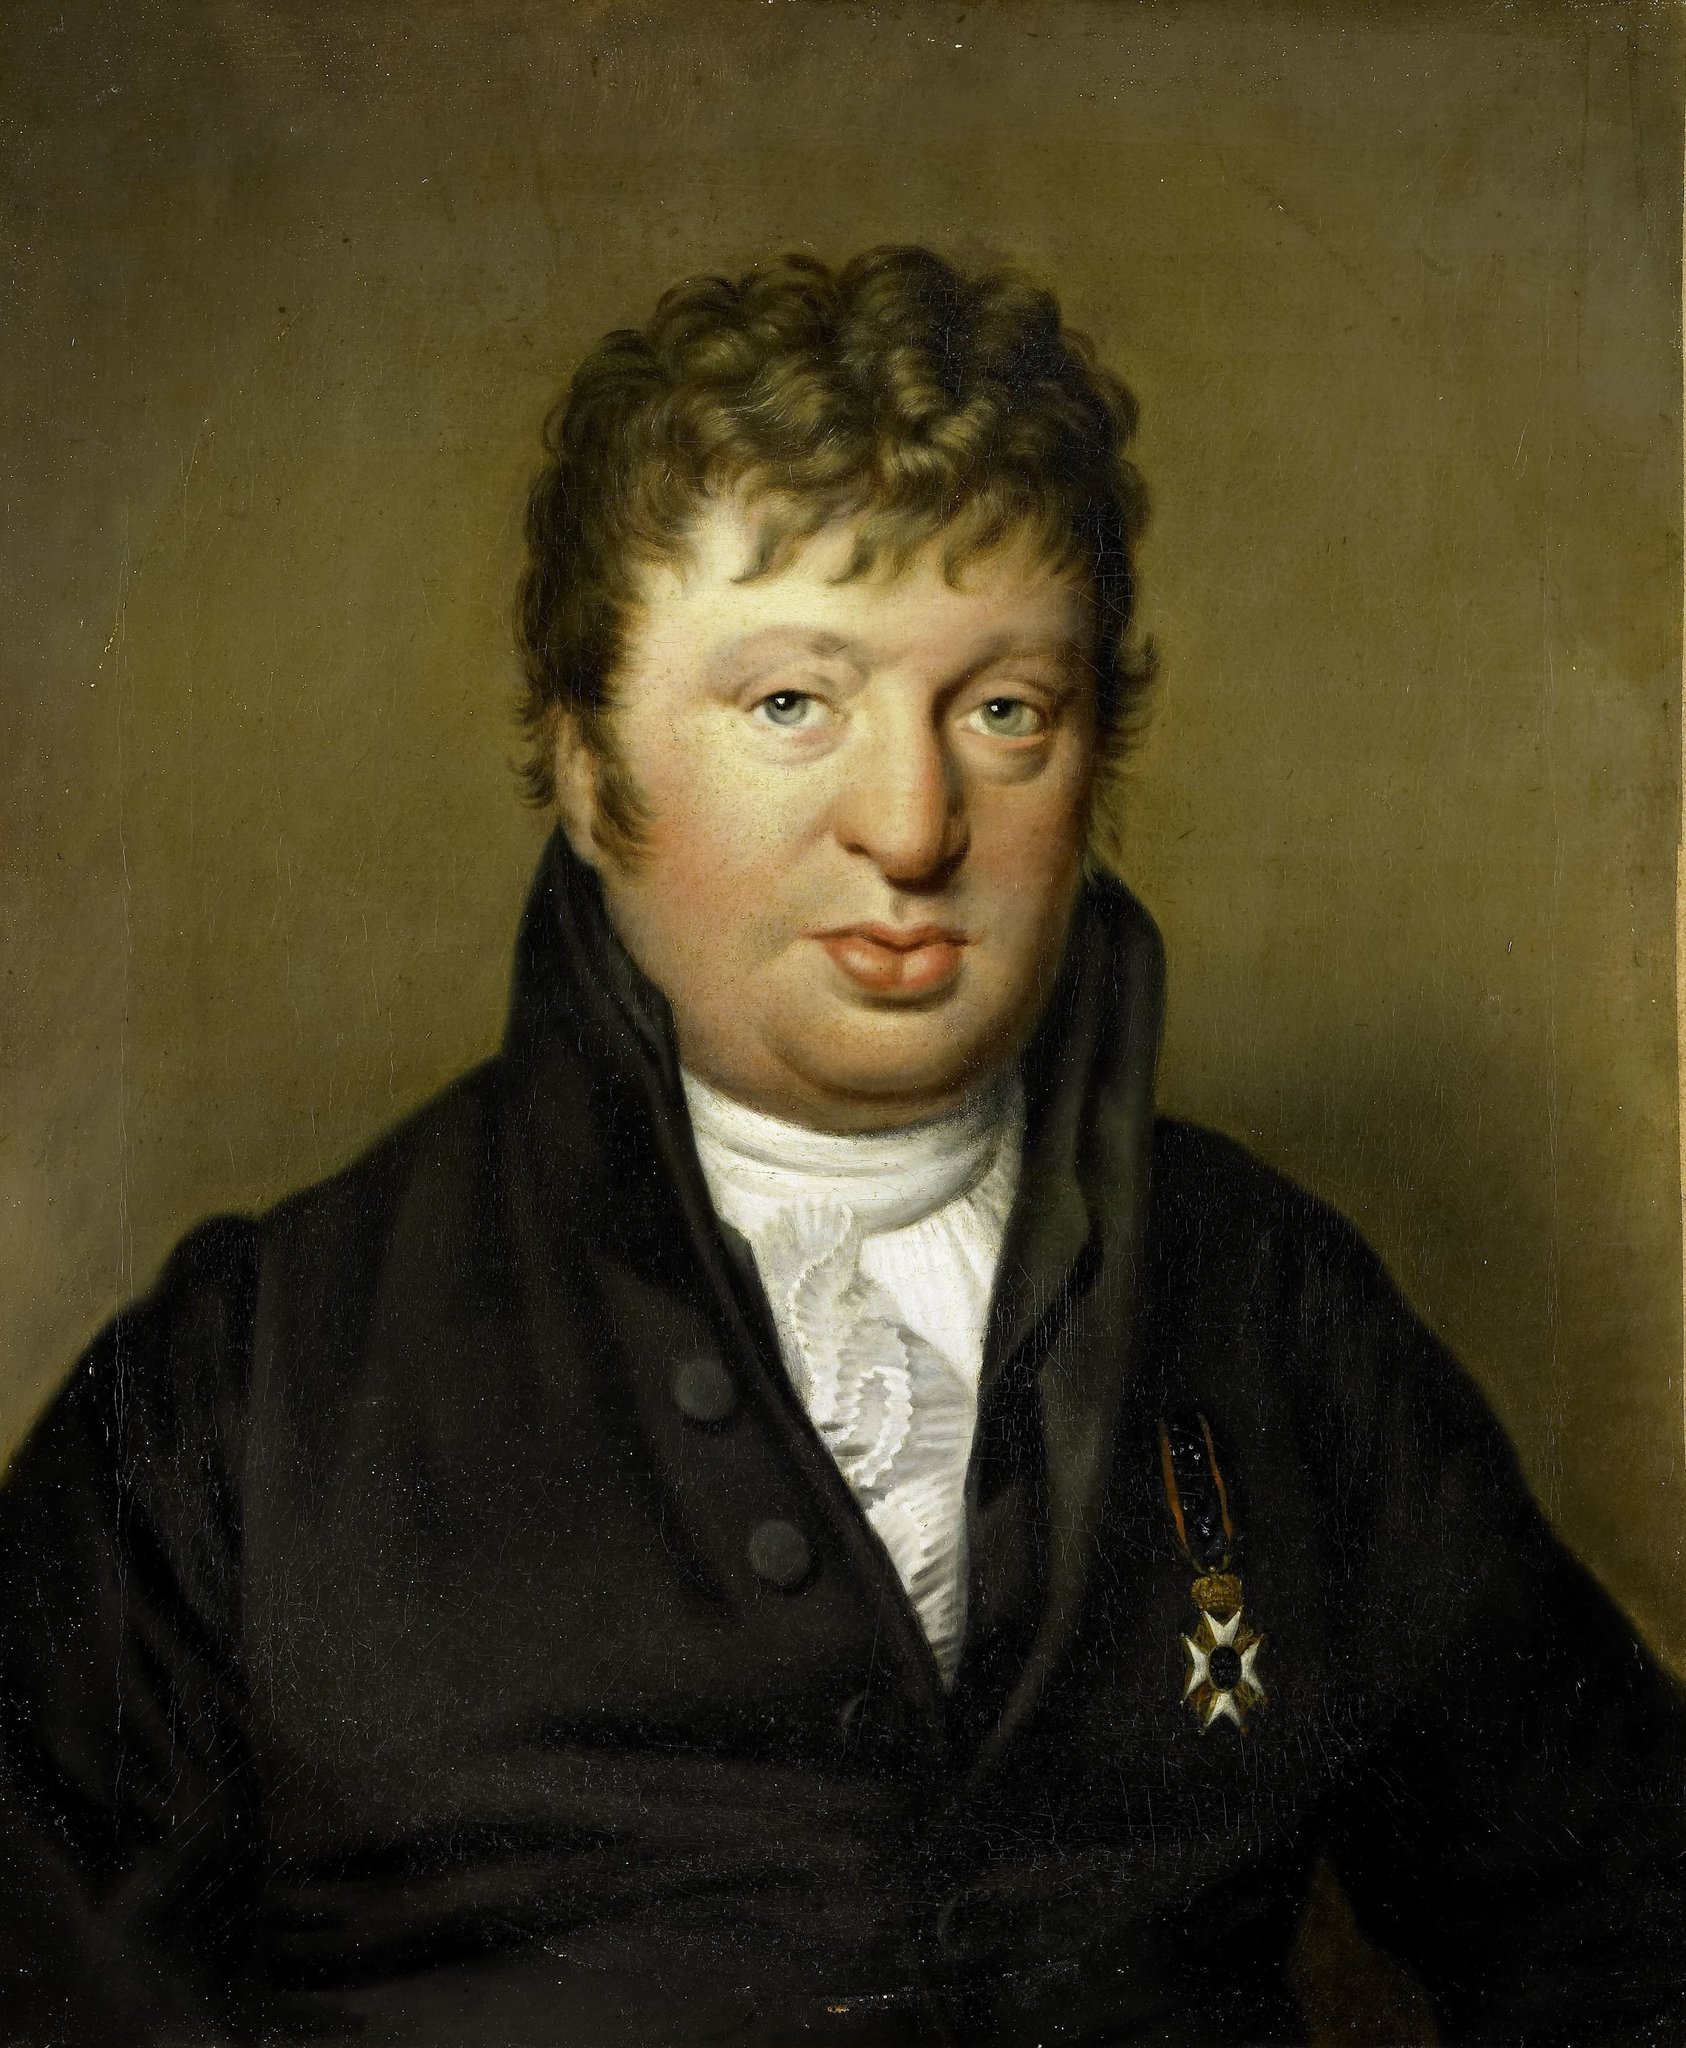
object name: painting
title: Jacobus Scheltema (1767-1835), Historian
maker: wilhelmina geertruida van idsinga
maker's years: 1788-1819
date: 1798-1819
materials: canvas, oil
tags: jacobus scheltema, historical persons, historical disciplines; philology (+ portrait of scholar, scientist)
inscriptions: signature: ‘W.G. van Idsinga Pinxit’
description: Portret van Jacobus Scheltema, geschiedschrijver. Buste, en face. Kopie door Idsinga naar het origineel door Van der Kooi.